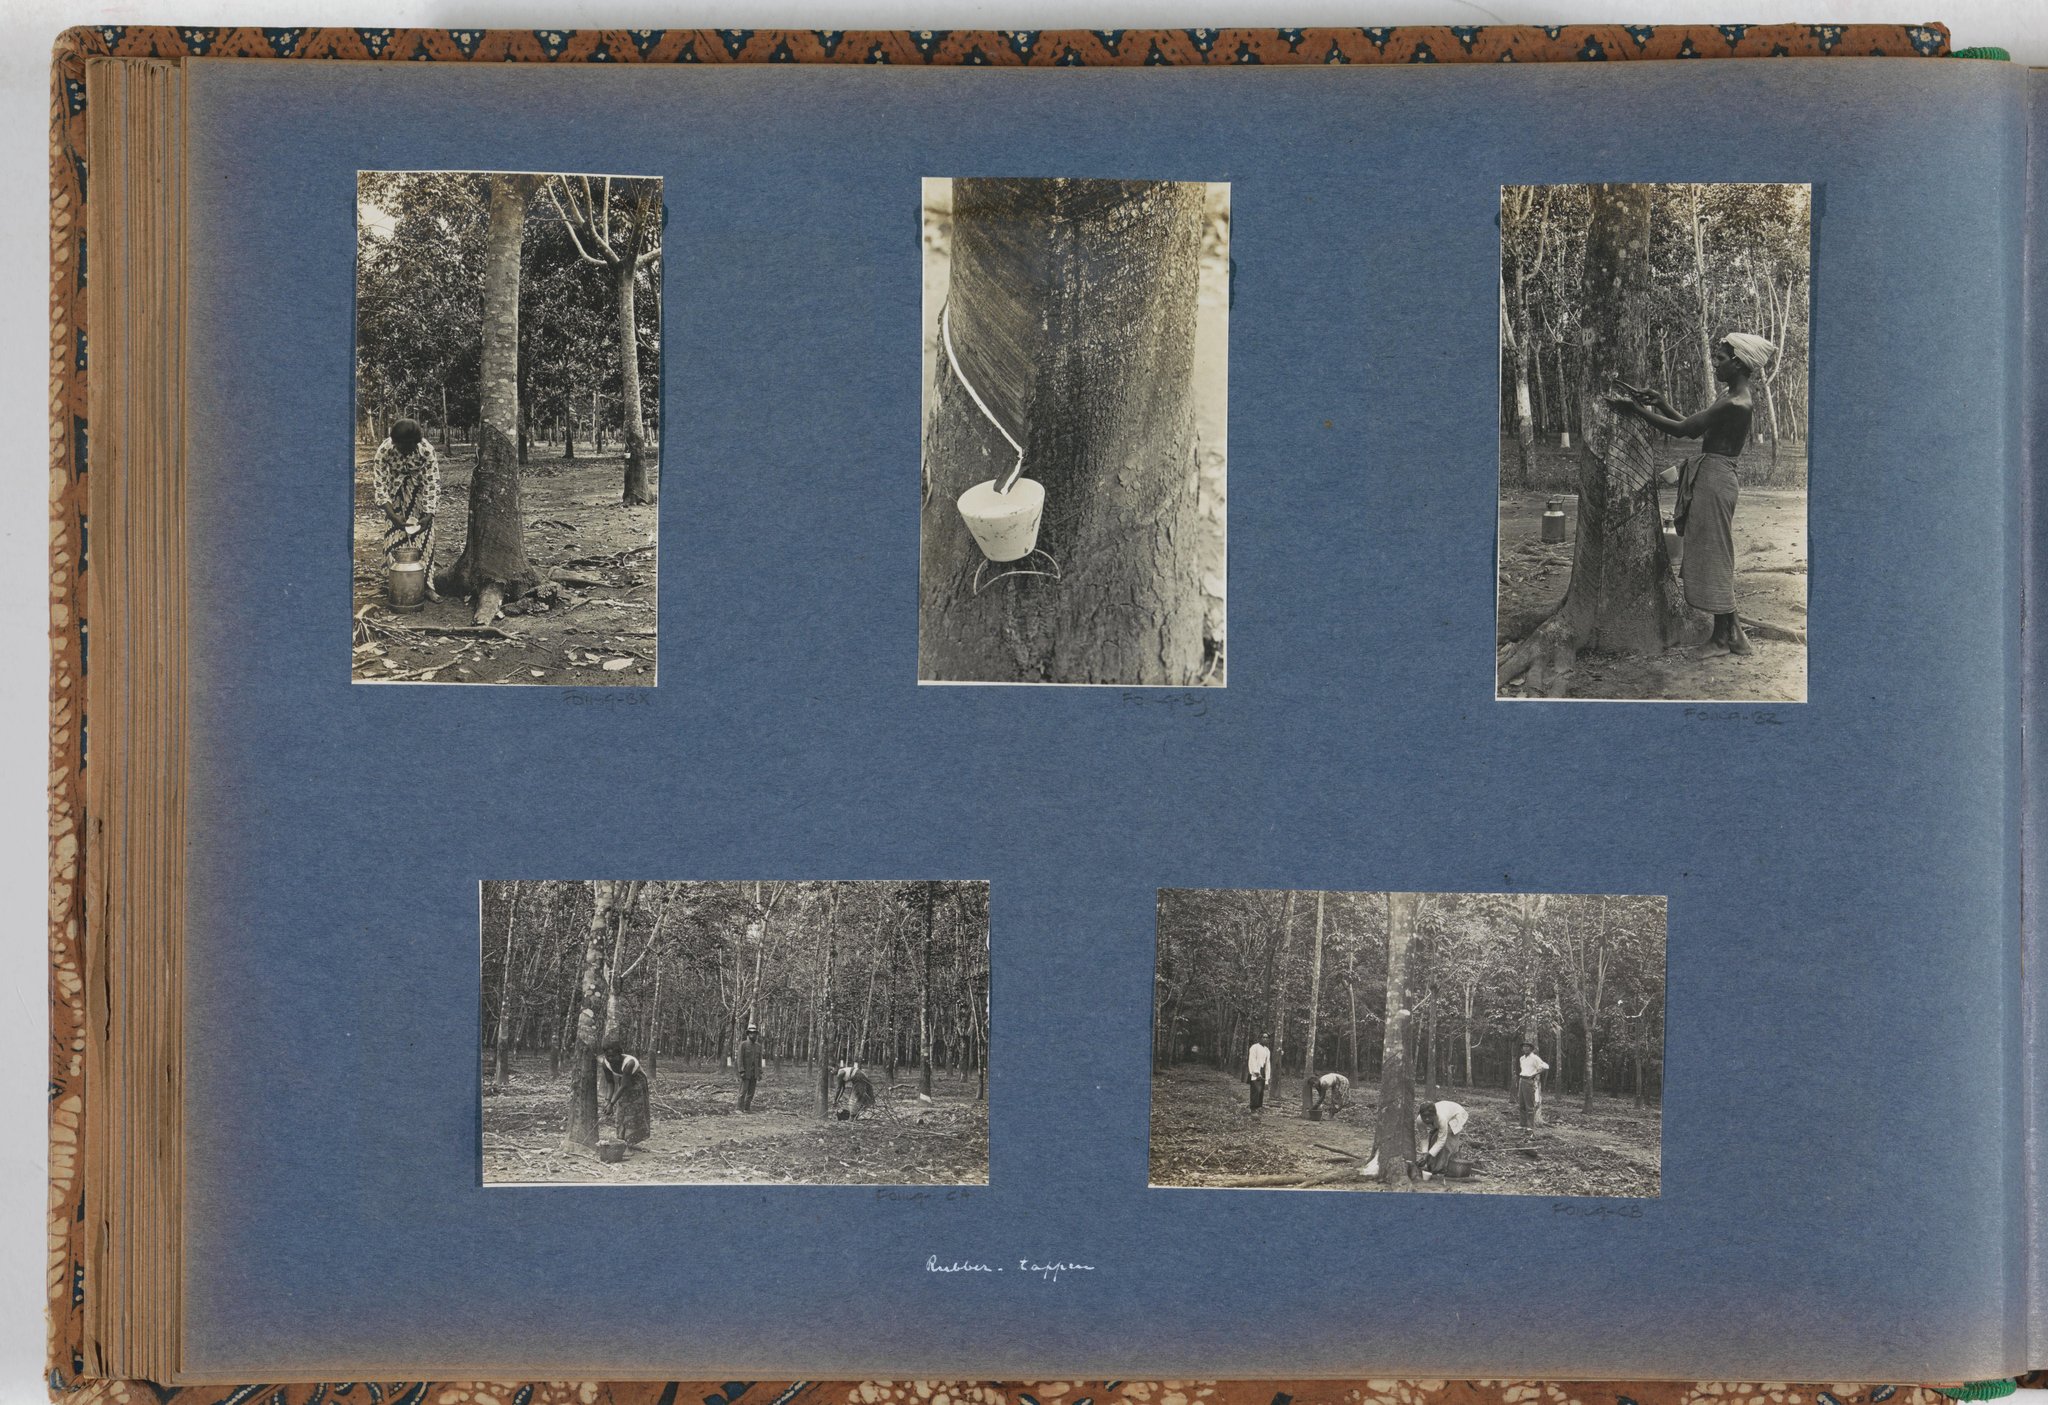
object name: photograph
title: Indische man kerft boomschors om rubber te tappen op Sumatra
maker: Anonymous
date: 1900-1920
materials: paper, photographic support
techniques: gelatin silver print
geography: sumatra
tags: plantation, (non-fruit) products of plants or trees: rubber, working class, labourers, sumatra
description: Mogelijk gaat het om een contractarbeider. Onderdeel van reisalbum met foto's van bedrijvigheid en bezienswaardigheden op Sumatra en Java en van de reis naar en van Nederlands-Indië.